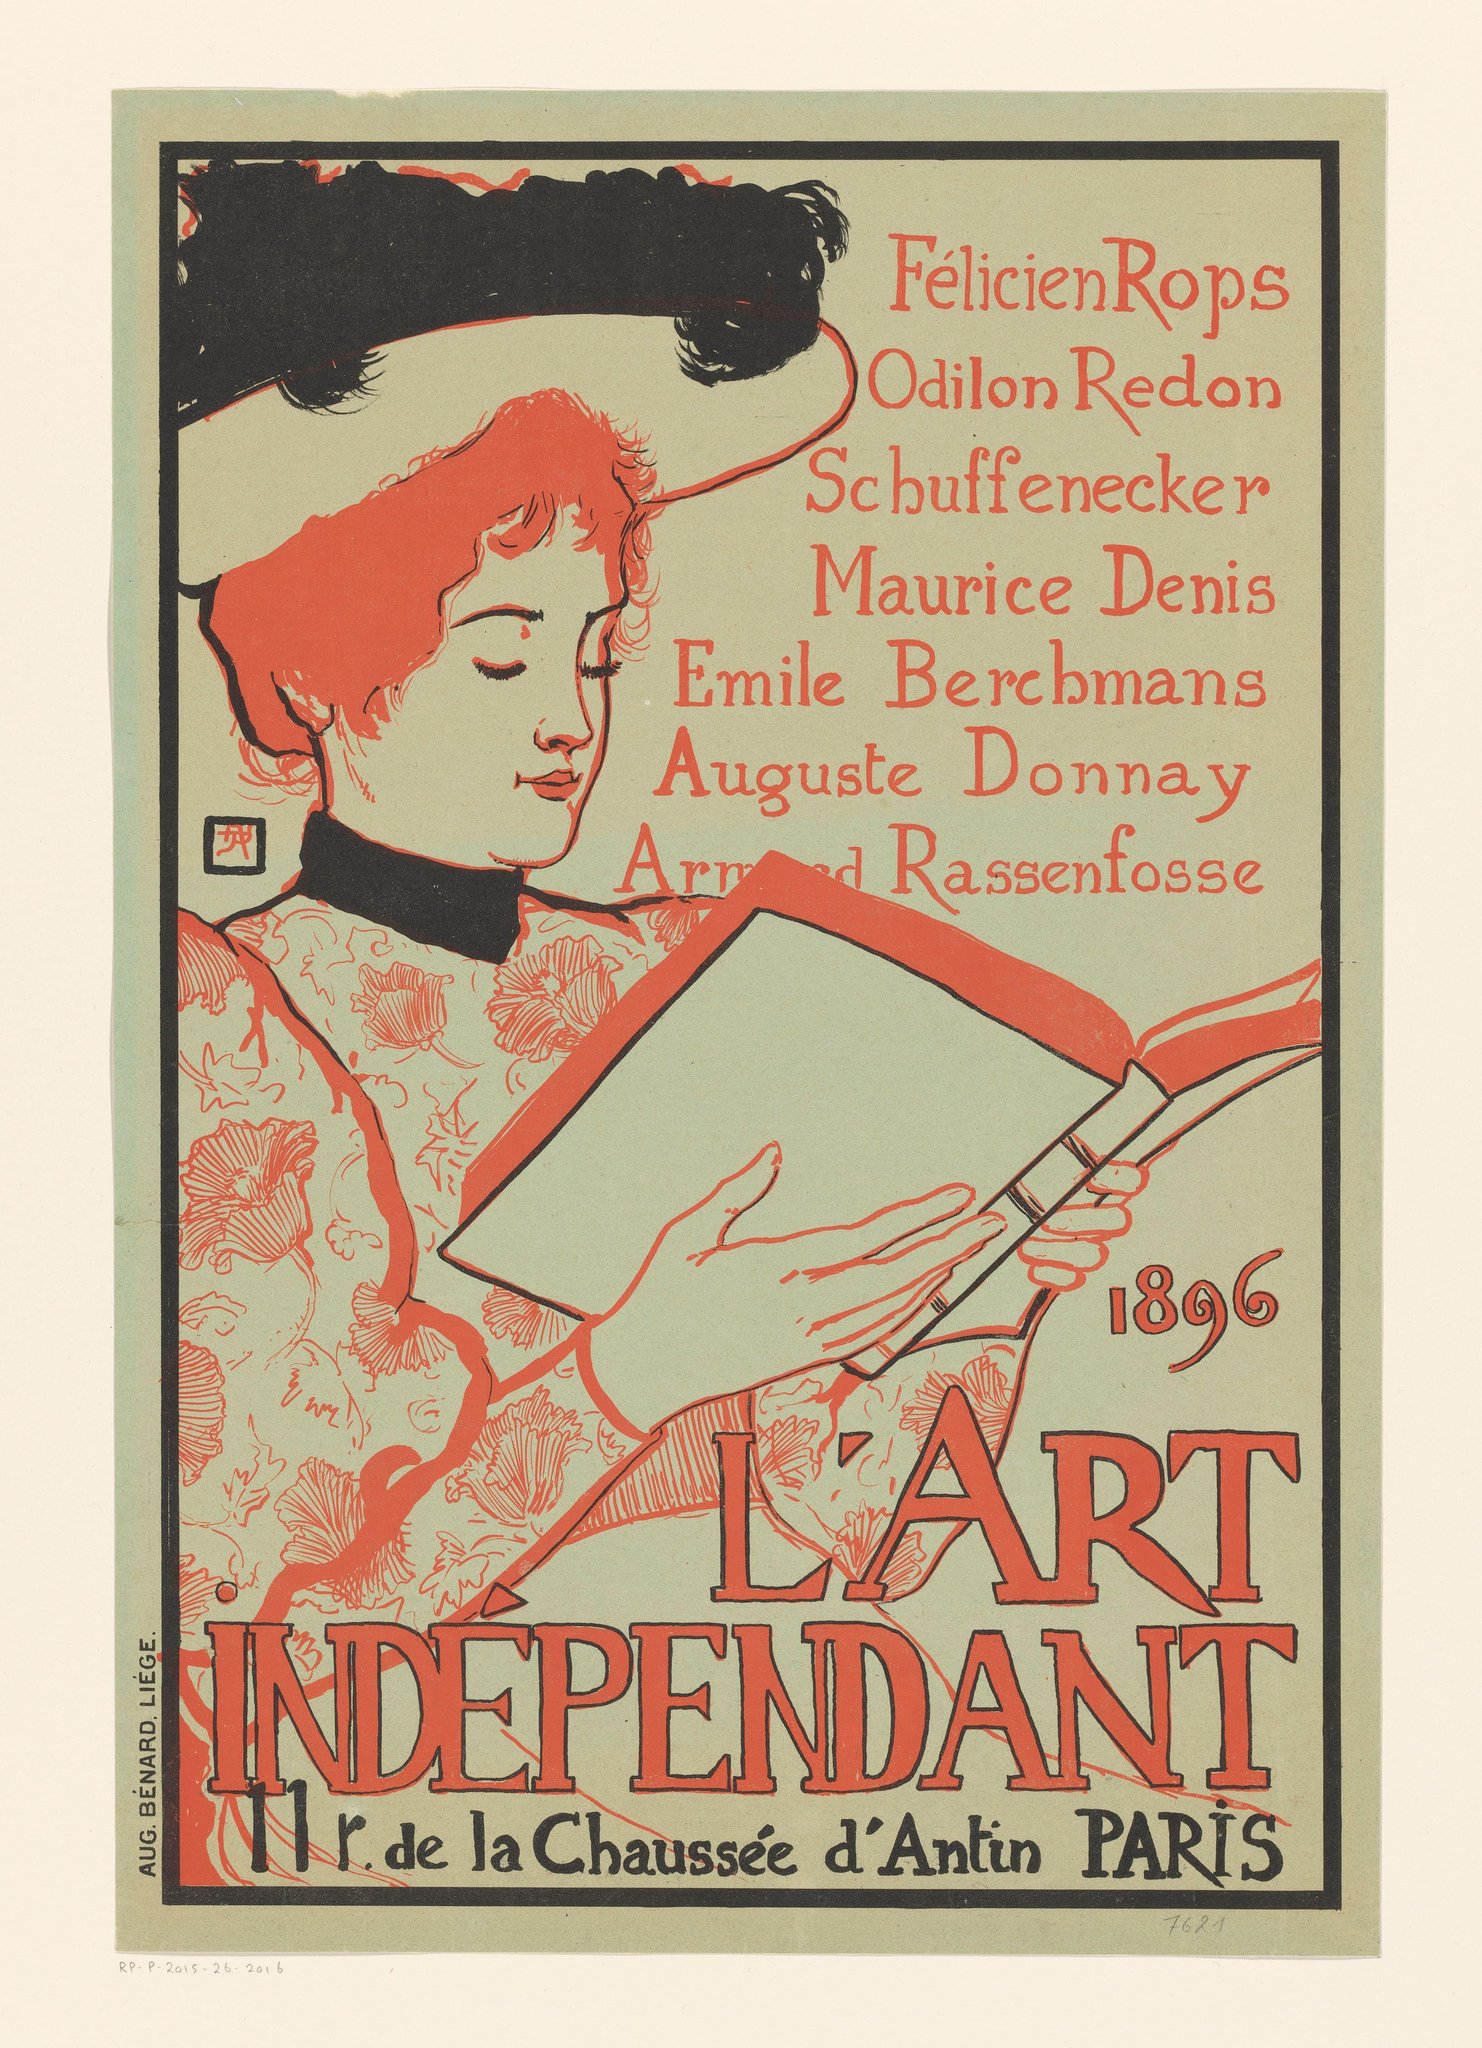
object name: poster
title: Affiche voor Librairie l'Art Indépendant te Parijs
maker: auguste bénard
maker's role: print maker, printer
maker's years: 1853-1907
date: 1896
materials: paper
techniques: lithograph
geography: liège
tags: reading, book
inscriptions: collector's mark: Lugt 2228, collector's mark: Lugt 4779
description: Portret van een vrouw met een hoed, lezend in een boek.